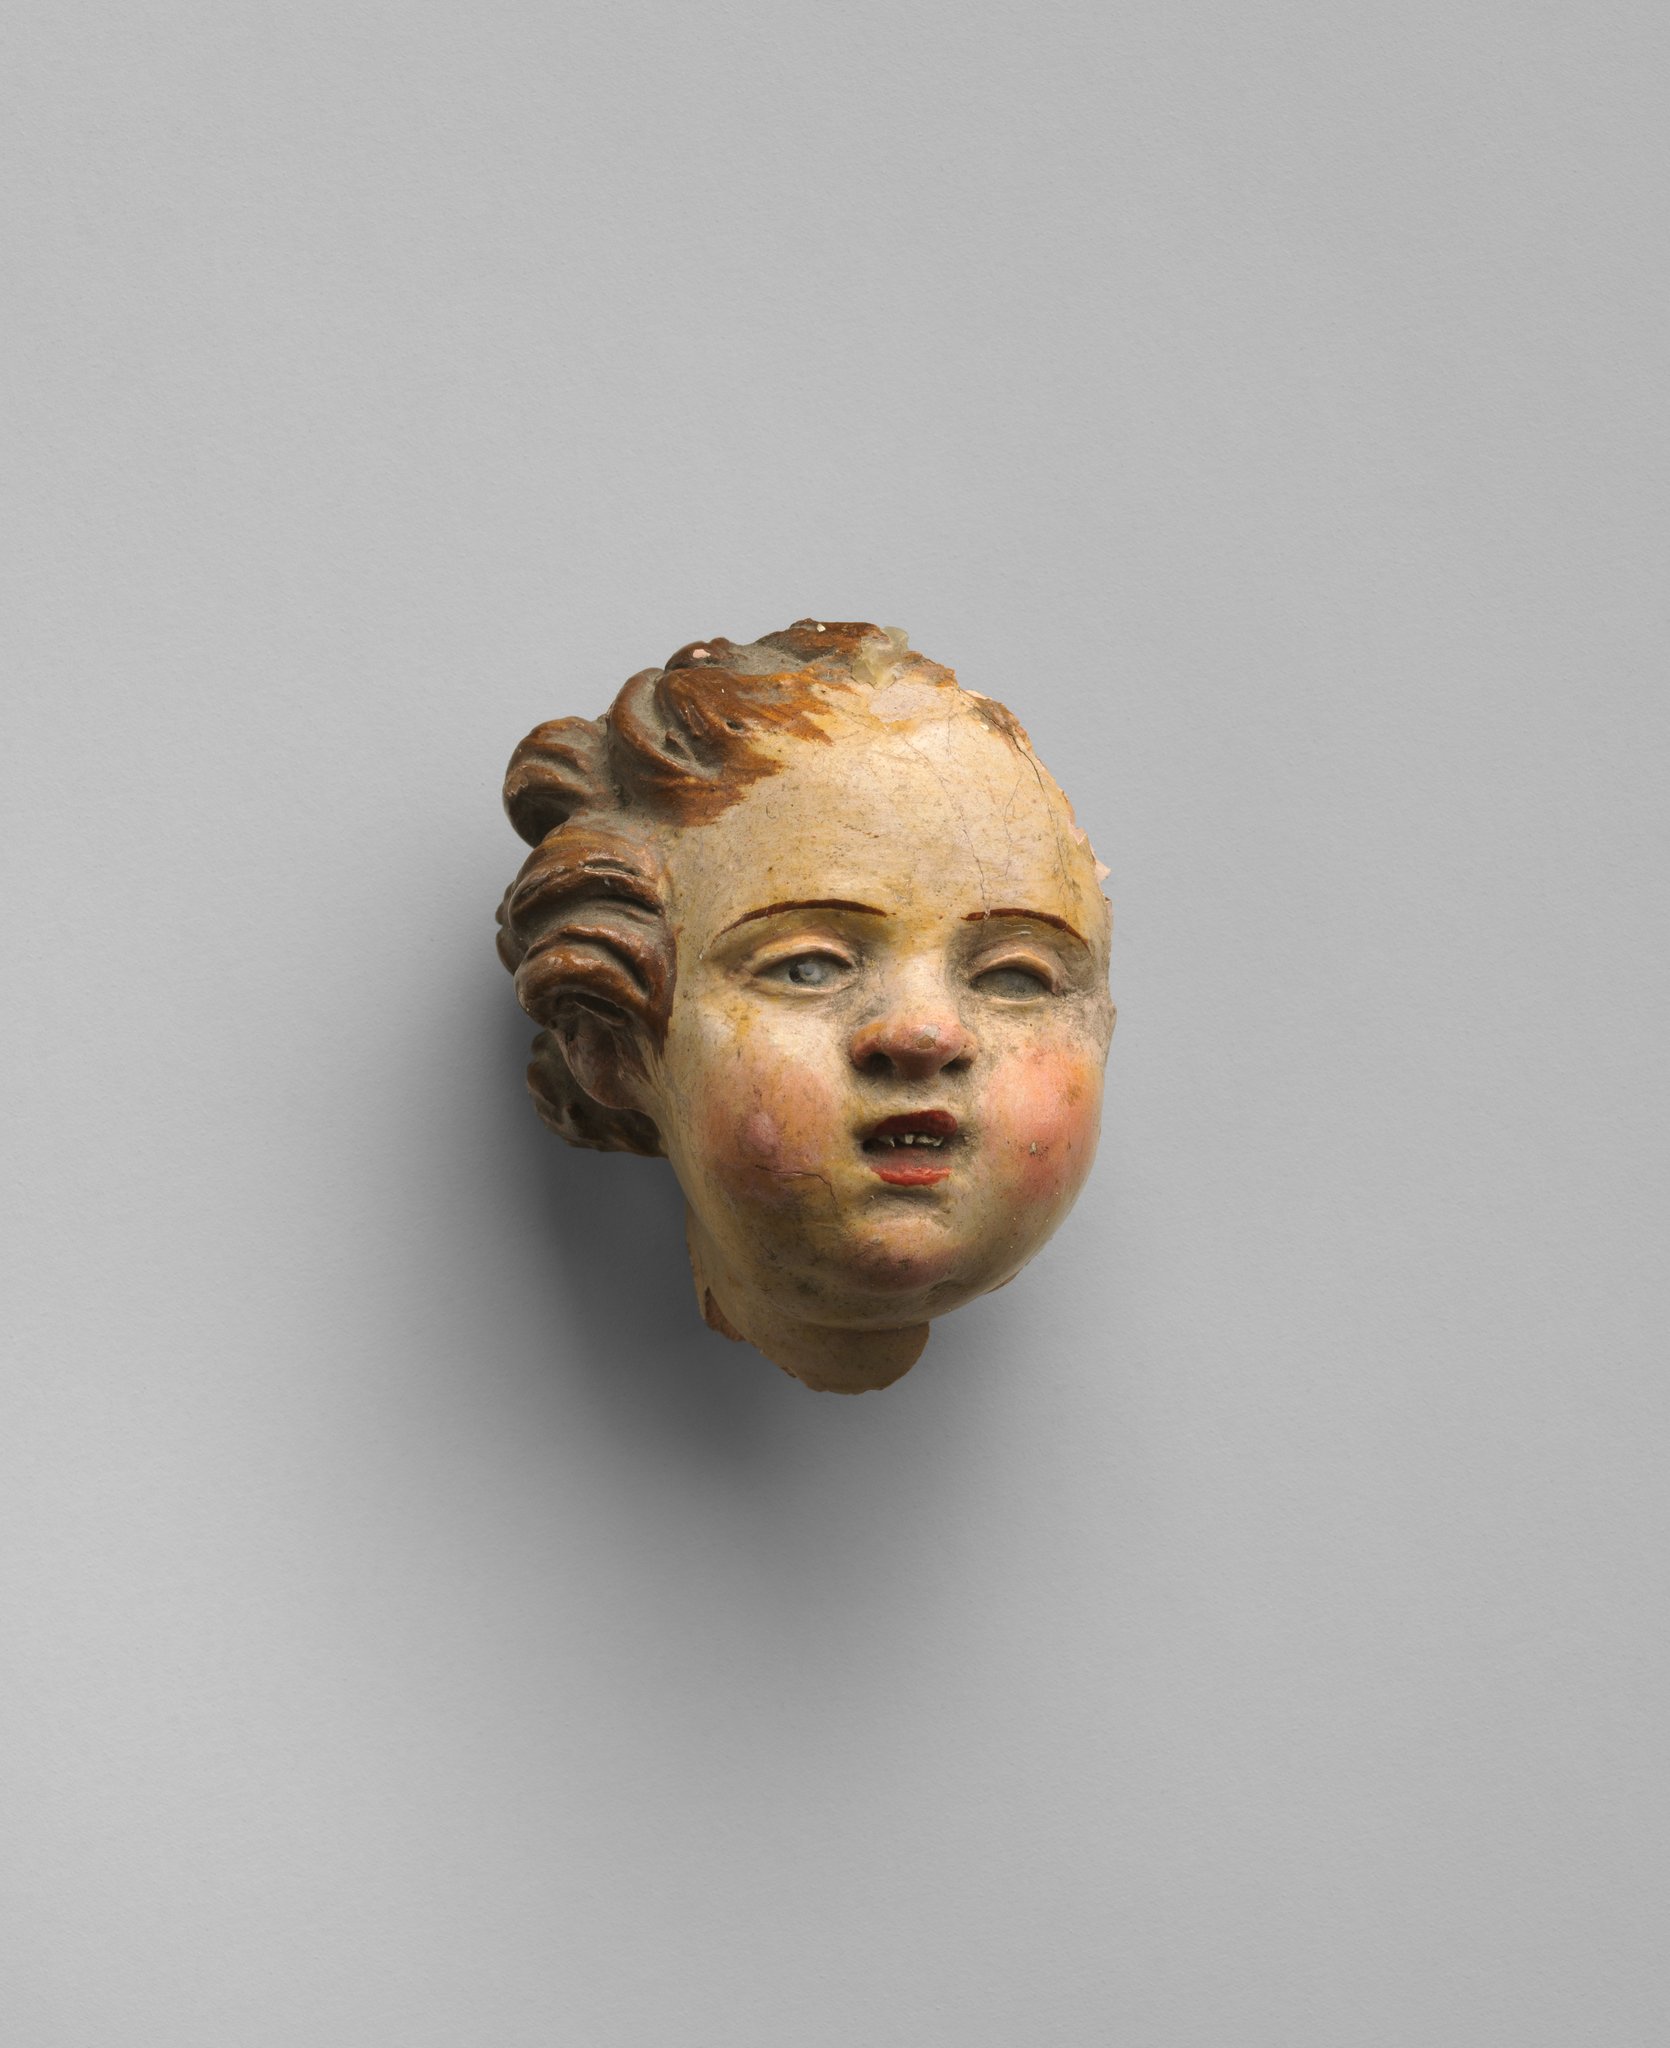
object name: crèche figure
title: Cherub head fragment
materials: terracotta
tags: heads